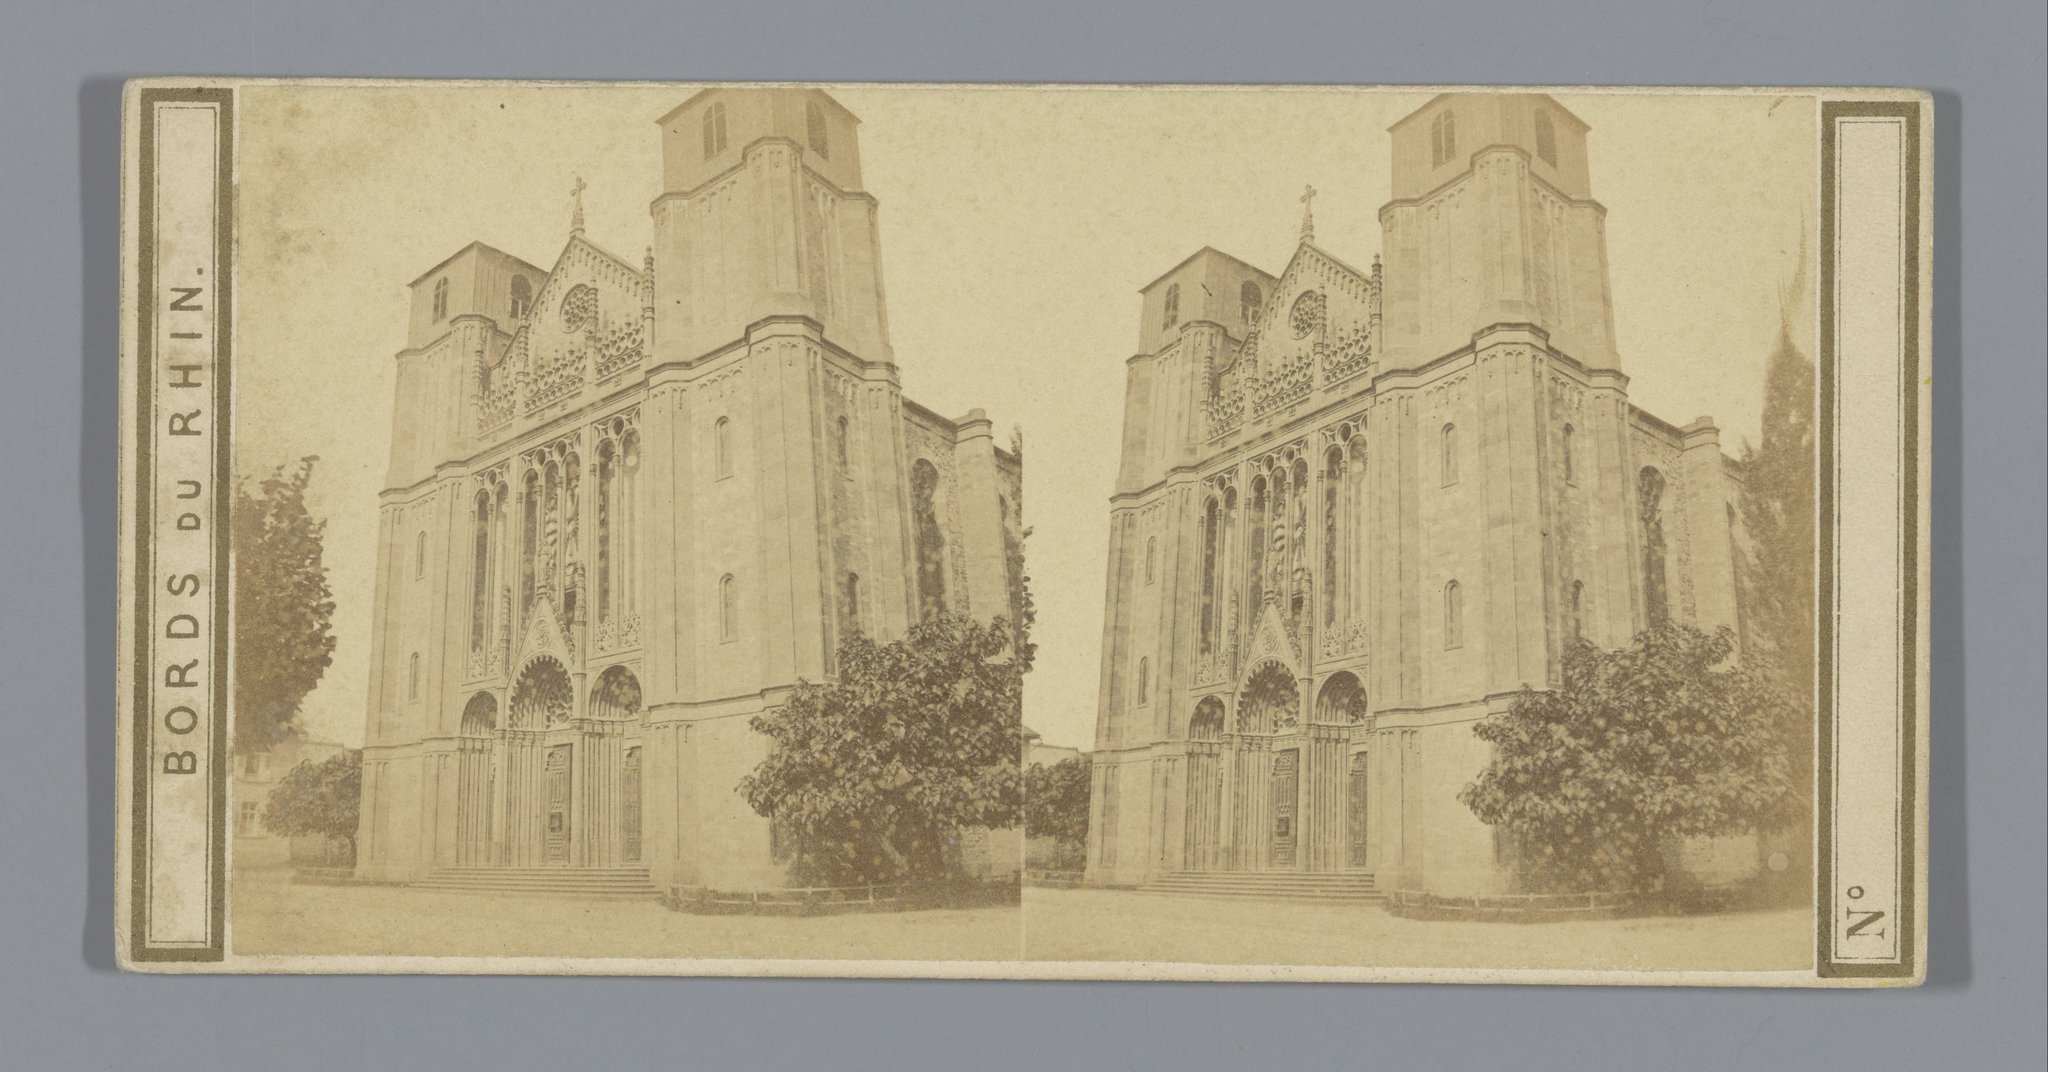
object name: stereograph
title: Bords du Rhin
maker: alexandre bertrand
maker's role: fotograaf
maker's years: 1822-1889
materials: cardboard, photographic support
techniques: albumen print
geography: utrecht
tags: church (exterior), façade (of house or building)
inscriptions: number: ‘162’, inscription: ‘La Cathédrale à Wiesbaden, Allemagne’, number: ‘162’